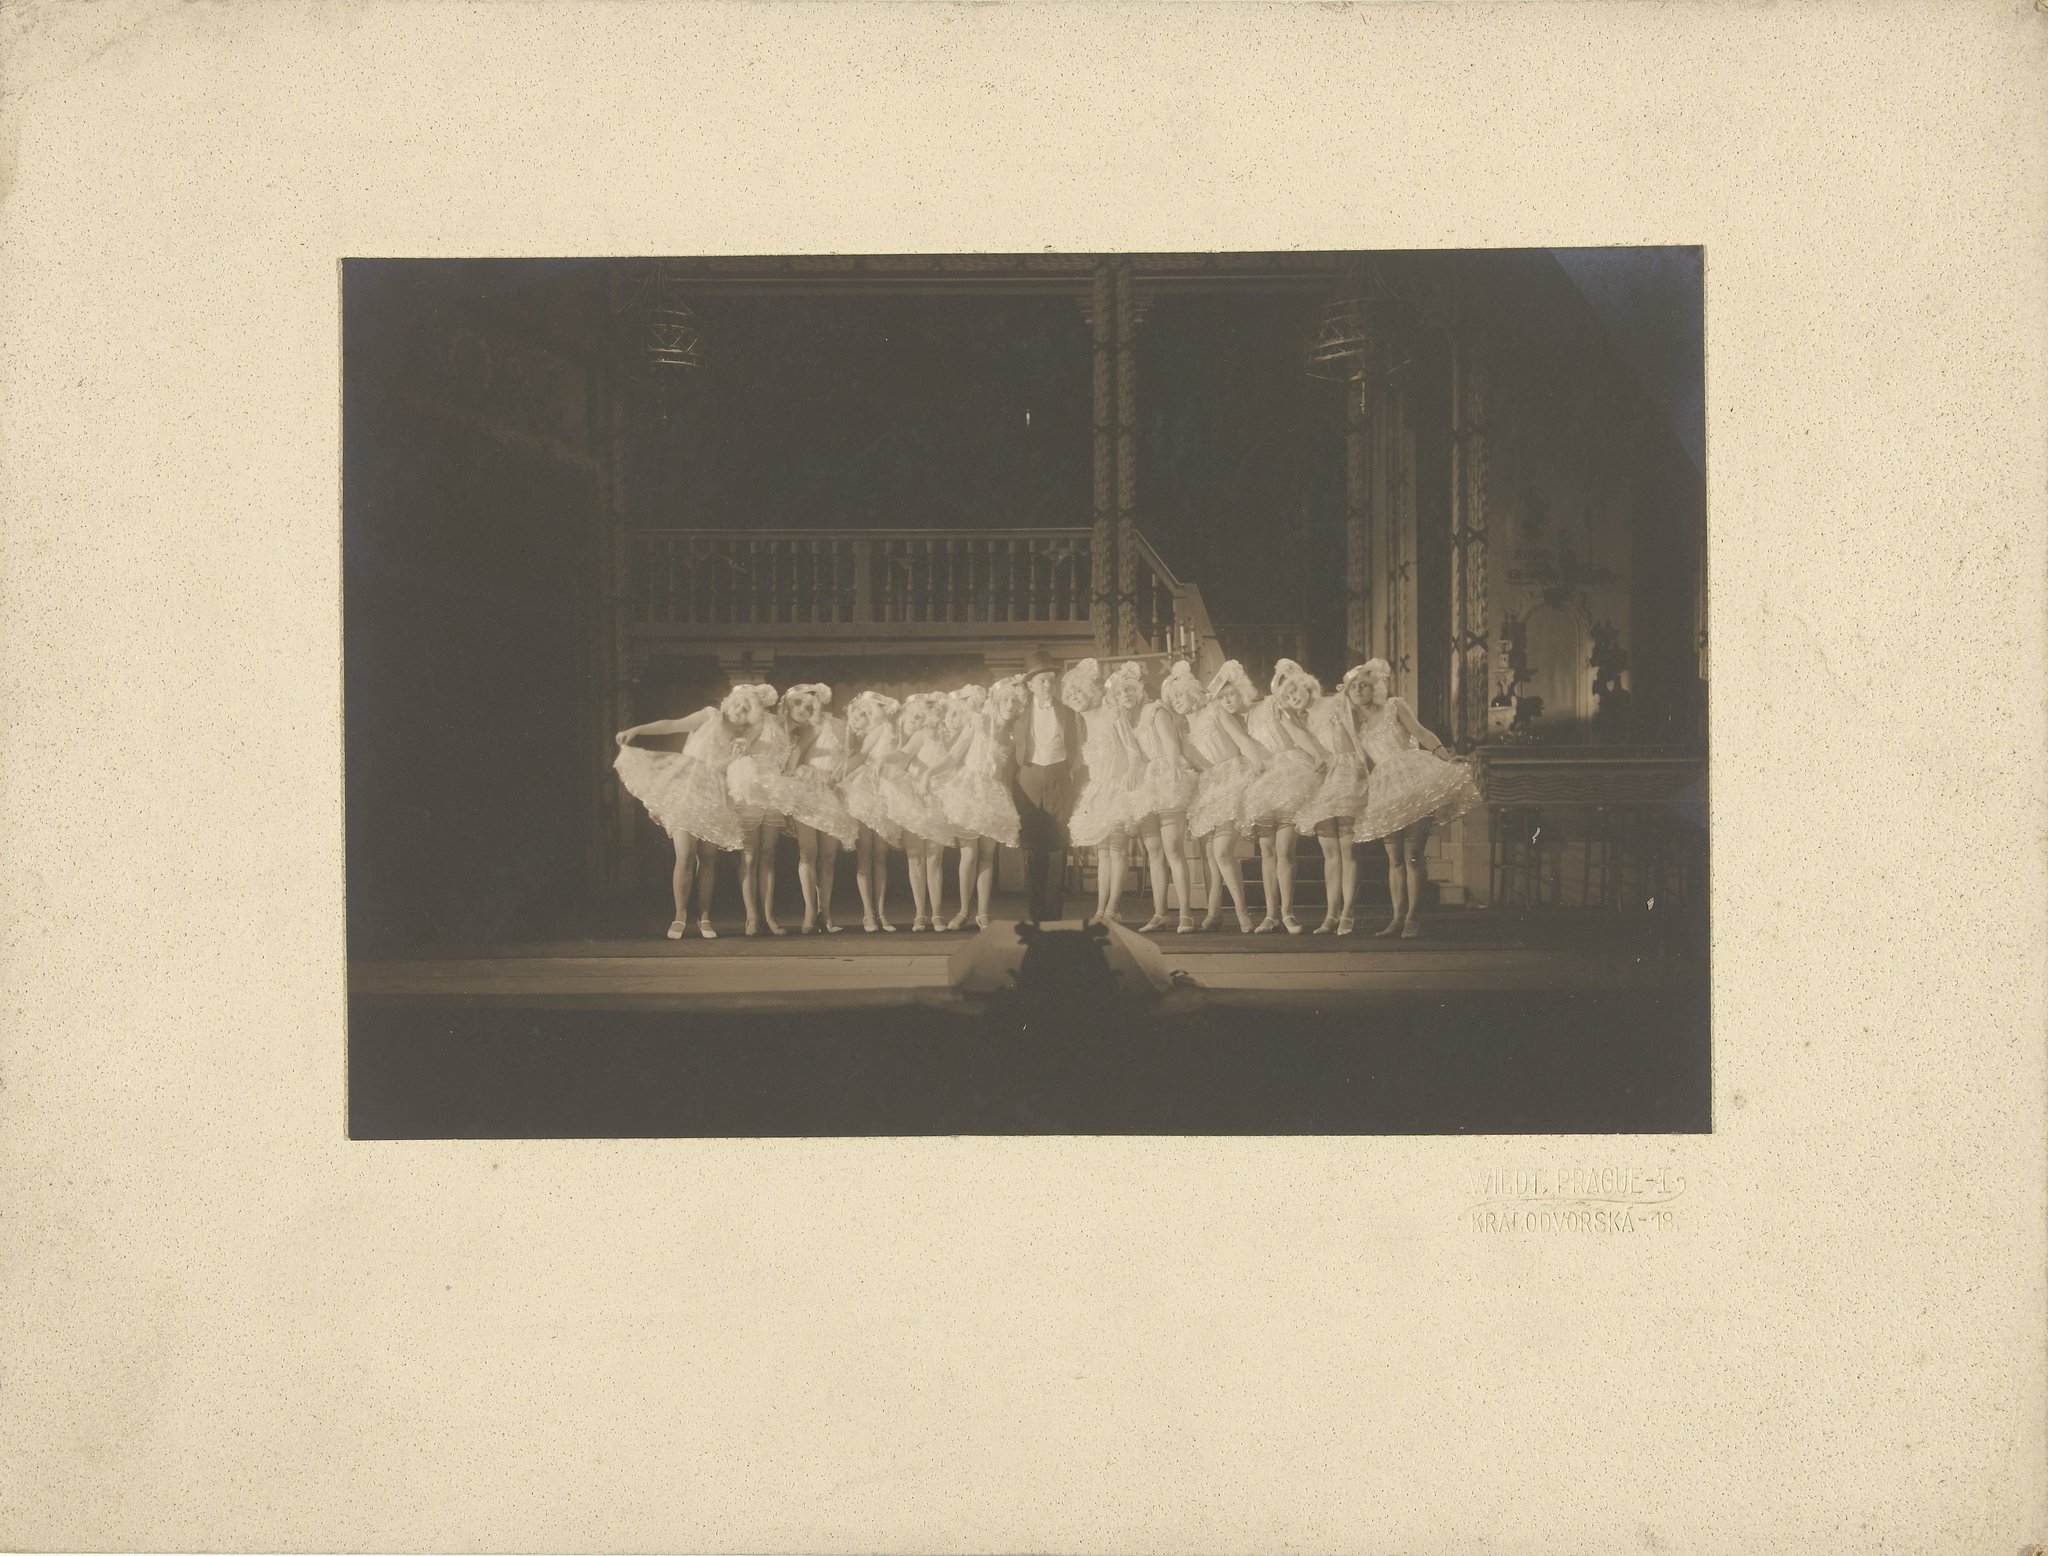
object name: photograph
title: Revuedanseressen en zanger op een toneel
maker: antonín wildt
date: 1920-1930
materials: paper, cardboard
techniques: gelatin silver print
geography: prague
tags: male singer, ballet group; dancers on the stage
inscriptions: address: ‘WILDT, PRAGUE-I./ KRÁLODVORSKÁ-18.’